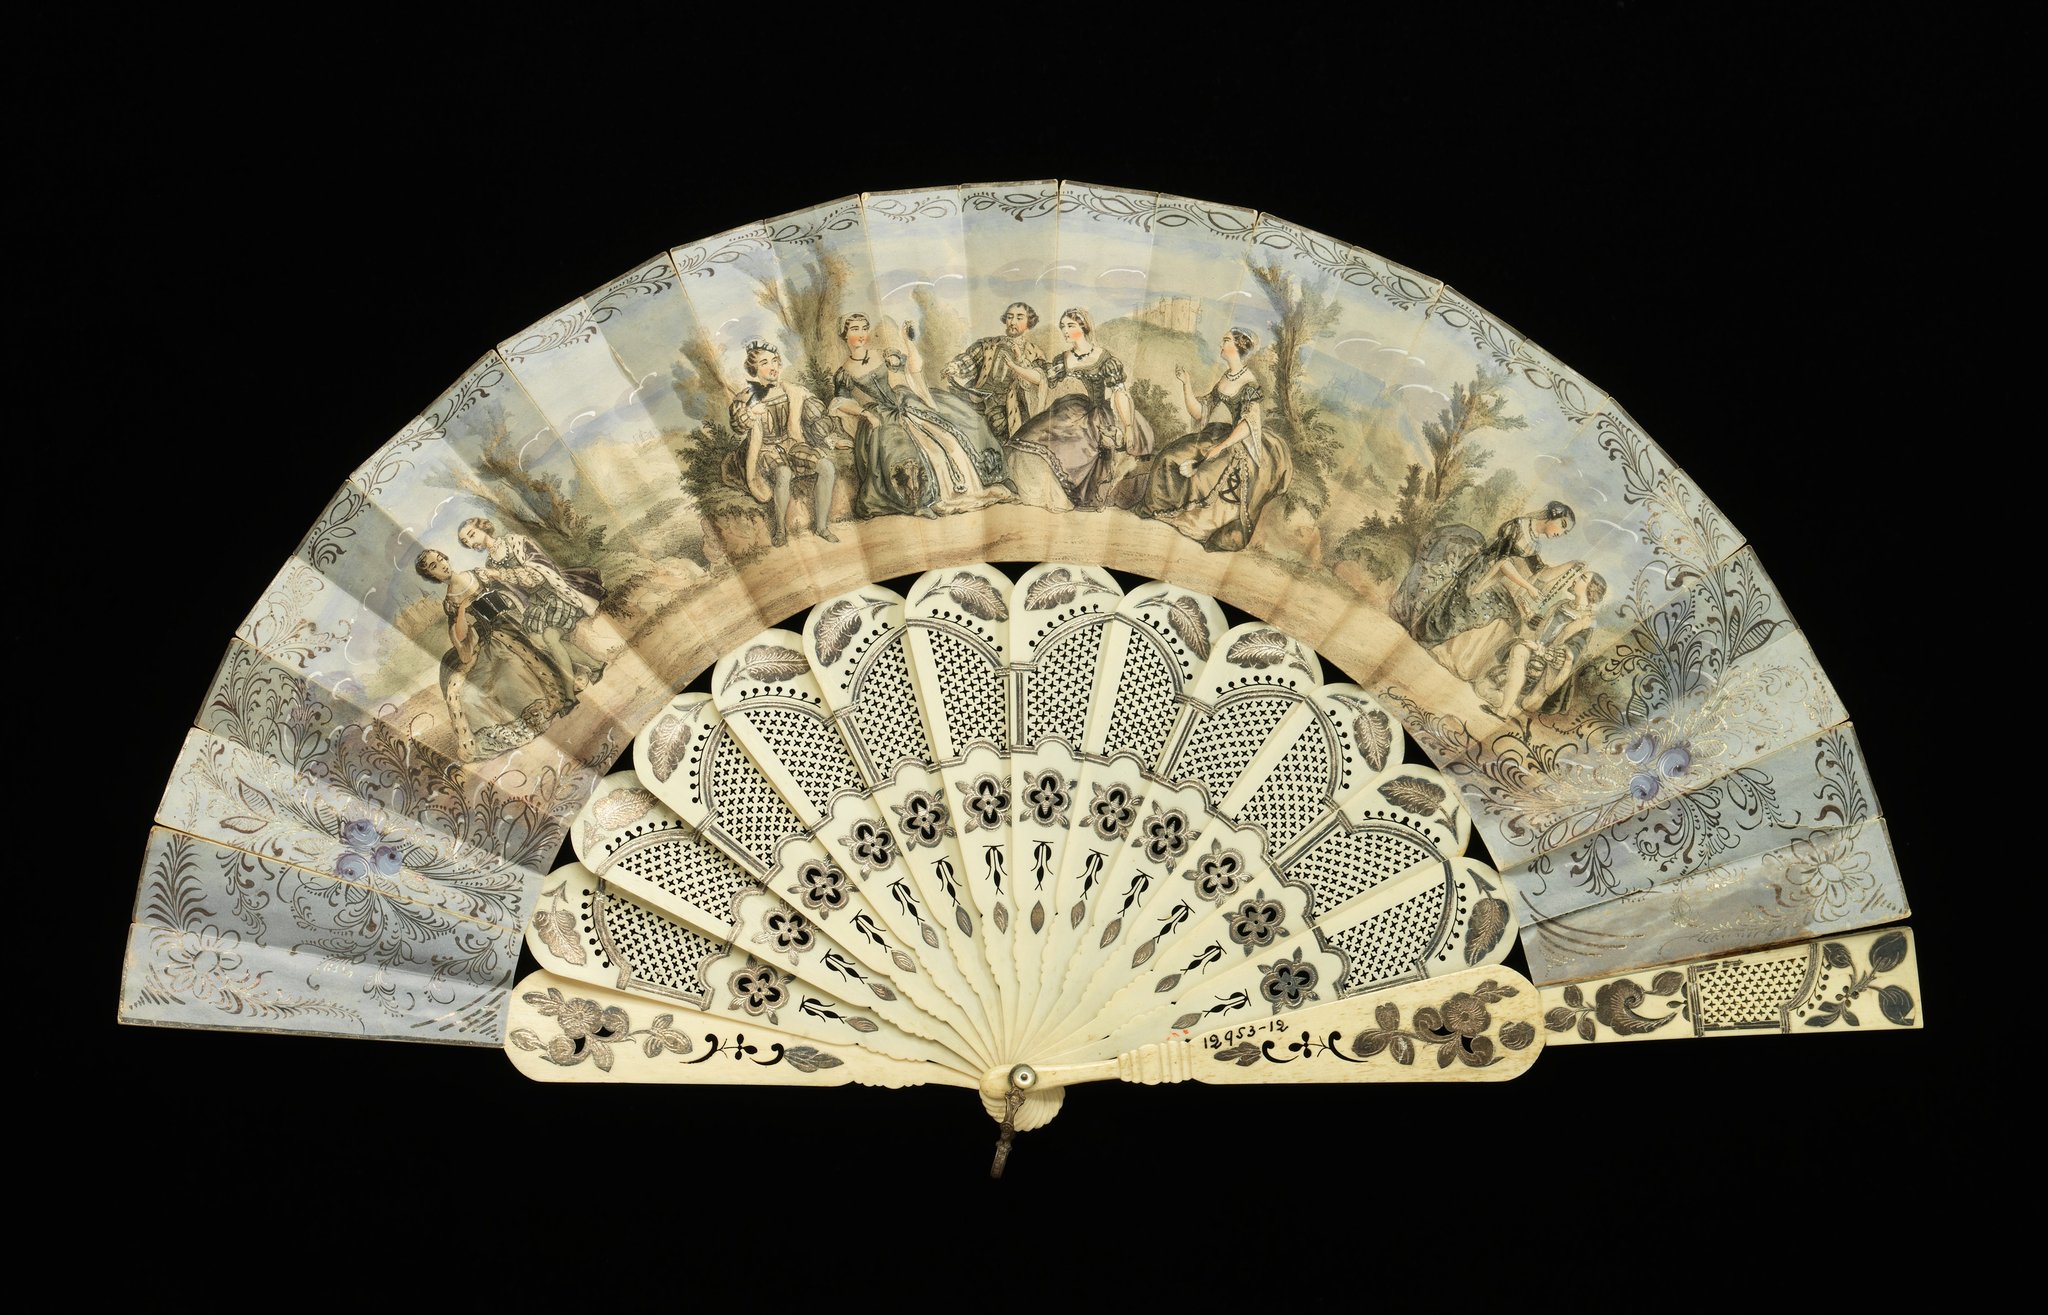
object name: fan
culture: british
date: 1851-1875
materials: gouache, ivory, metal, mother of pearl, paper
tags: men,women,landscapes